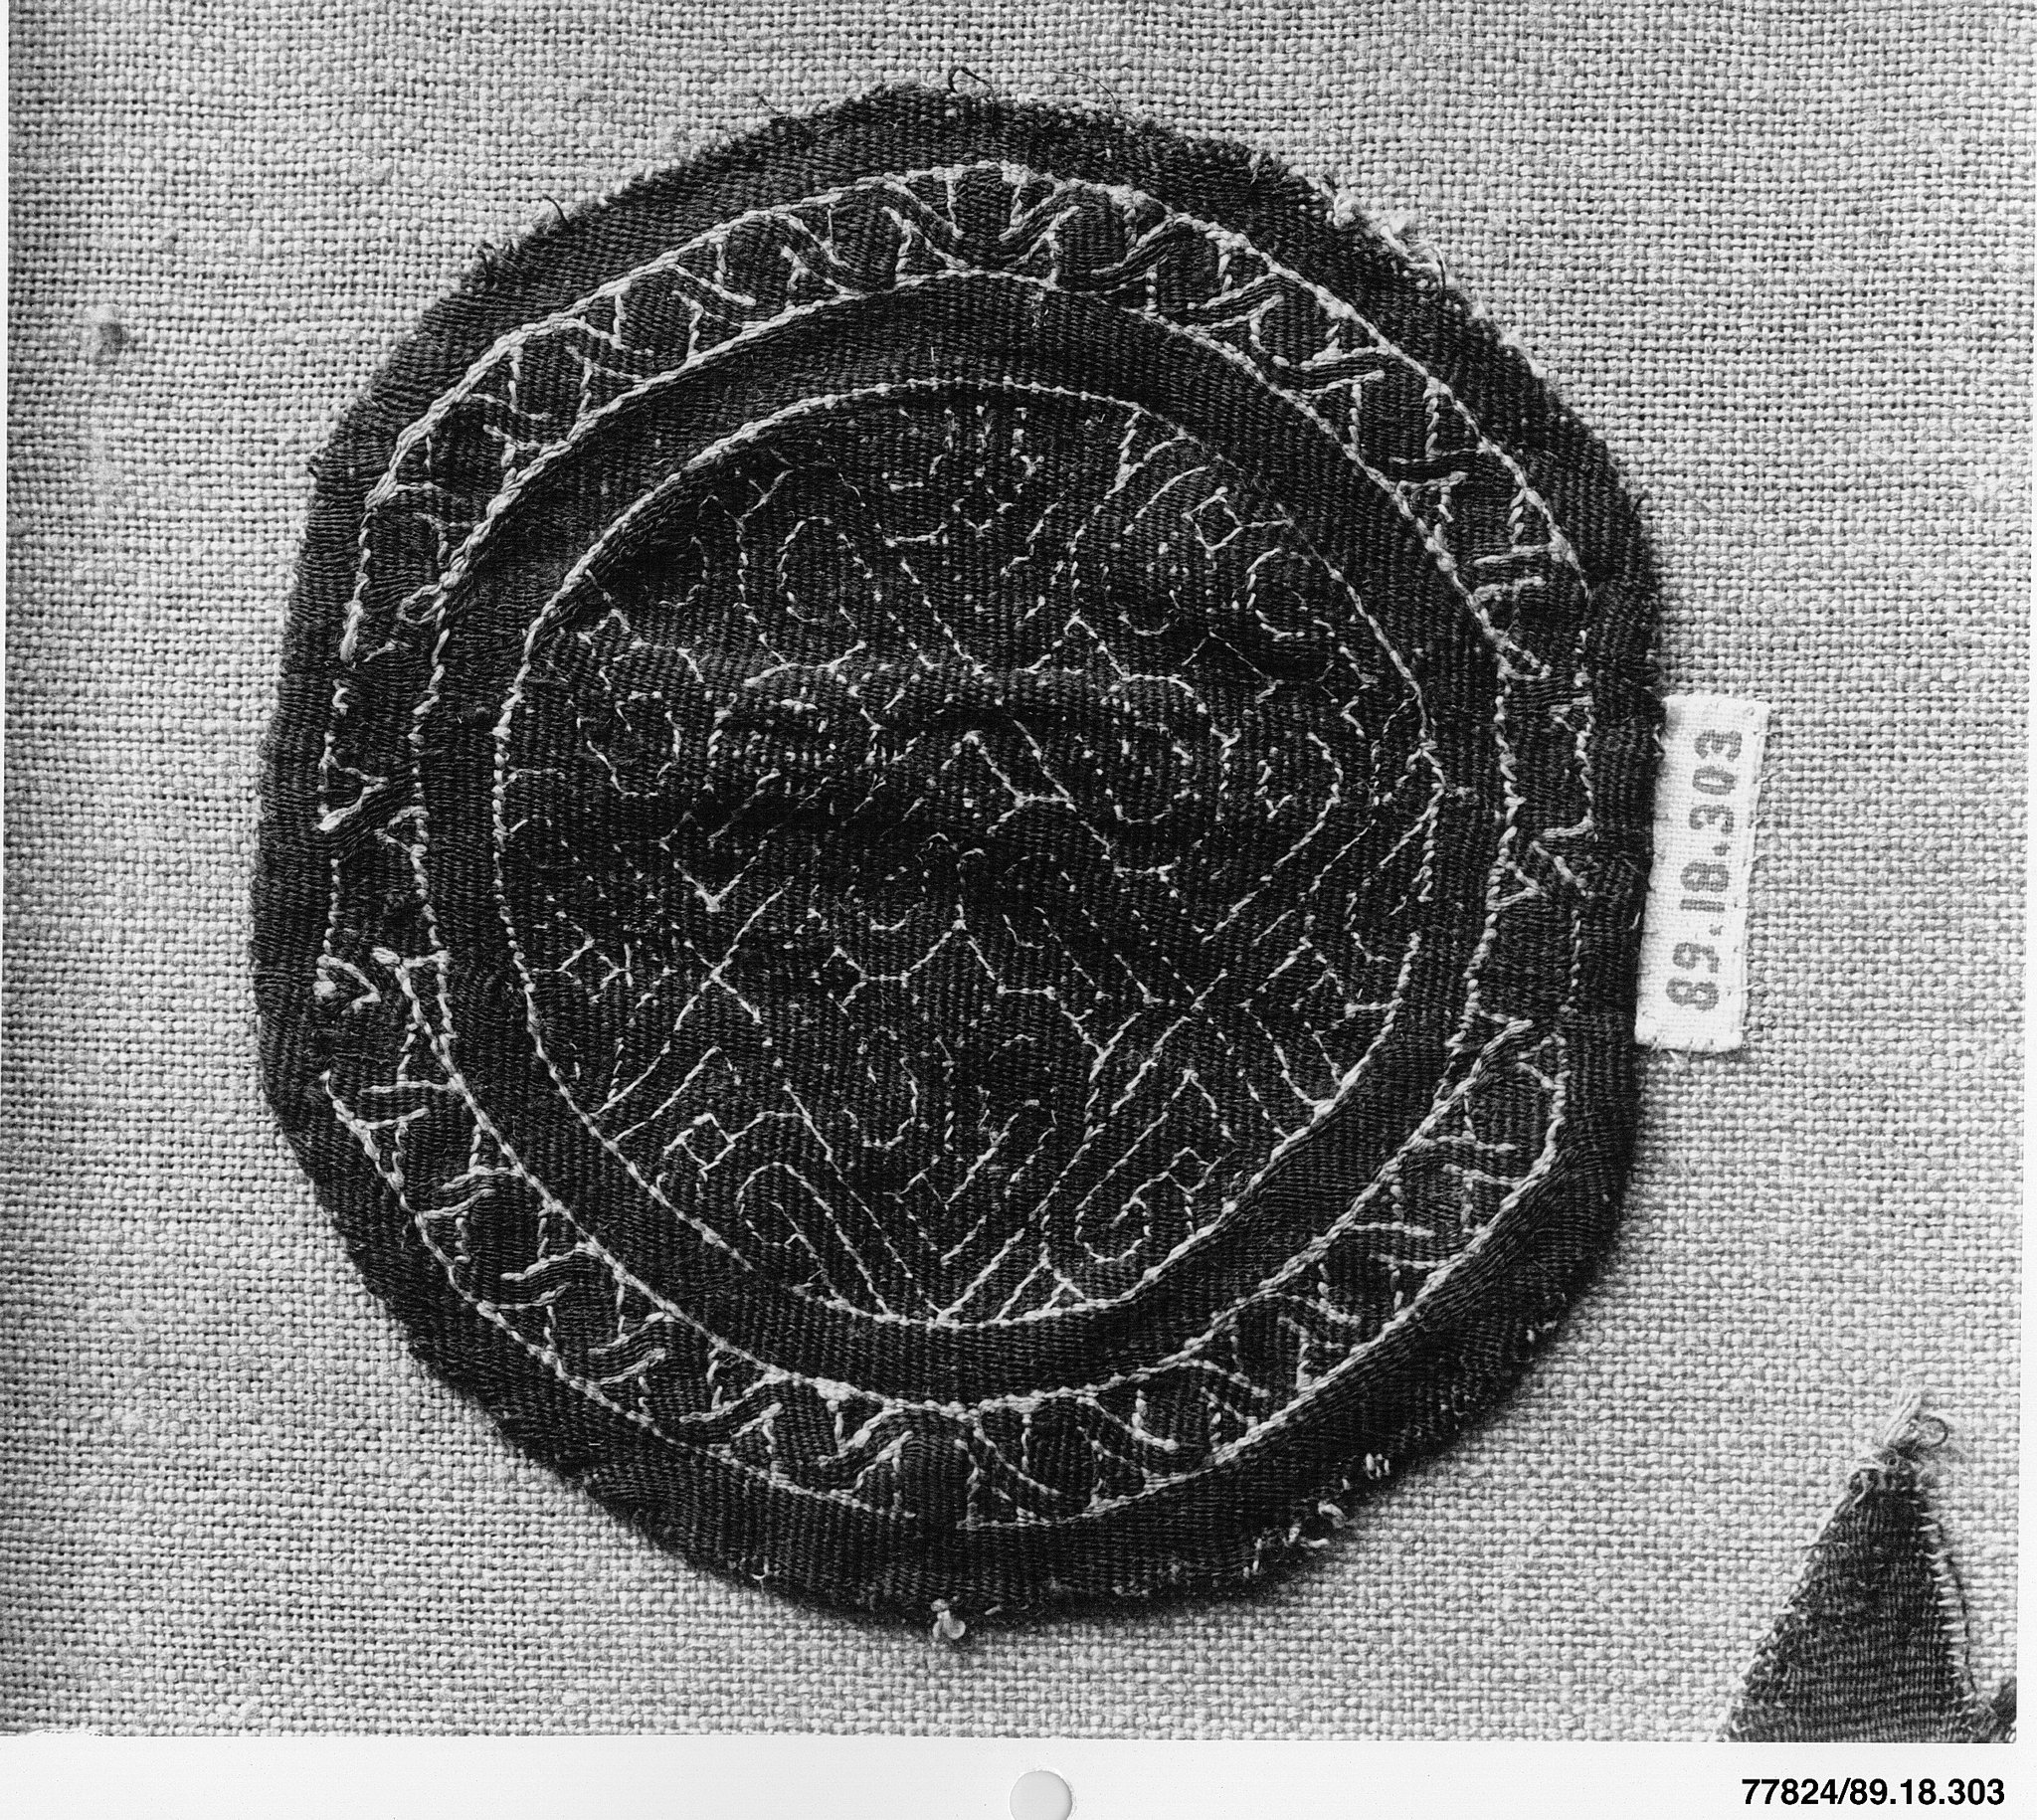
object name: textile fragment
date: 201-400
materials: linen, wool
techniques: weave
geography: egypt